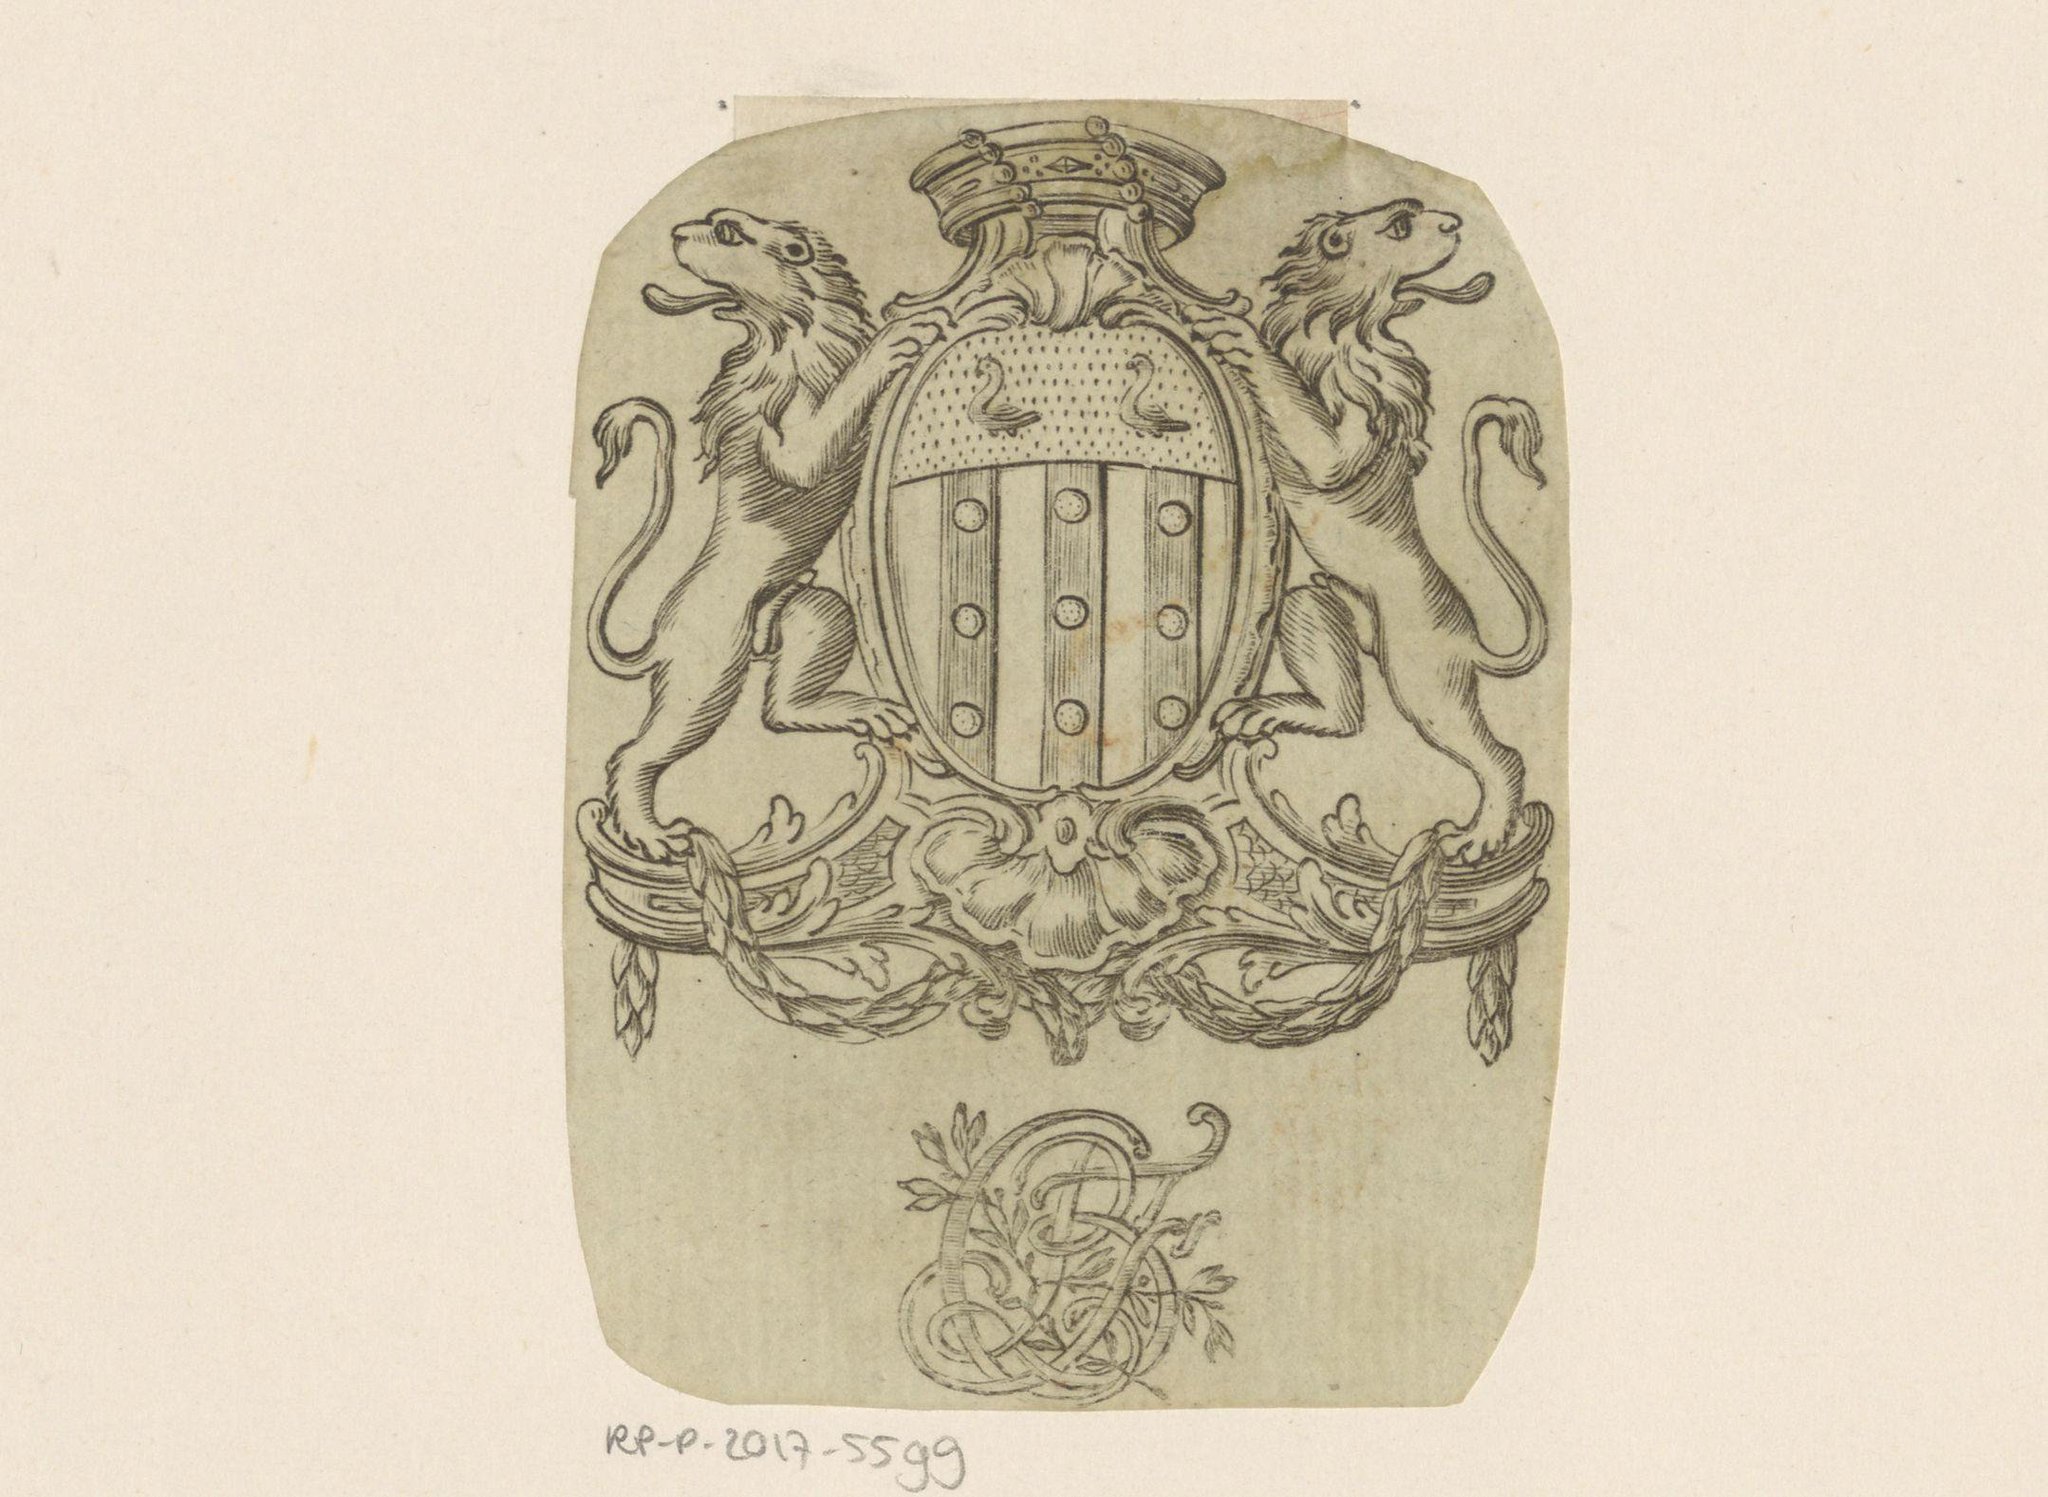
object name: bookplate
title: Ex libris van C.B.F.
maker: Anonymous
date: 1750-1799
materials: paper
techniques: etching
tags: beasts of prey, predatory animals: lion, armorial bearing, heraldry